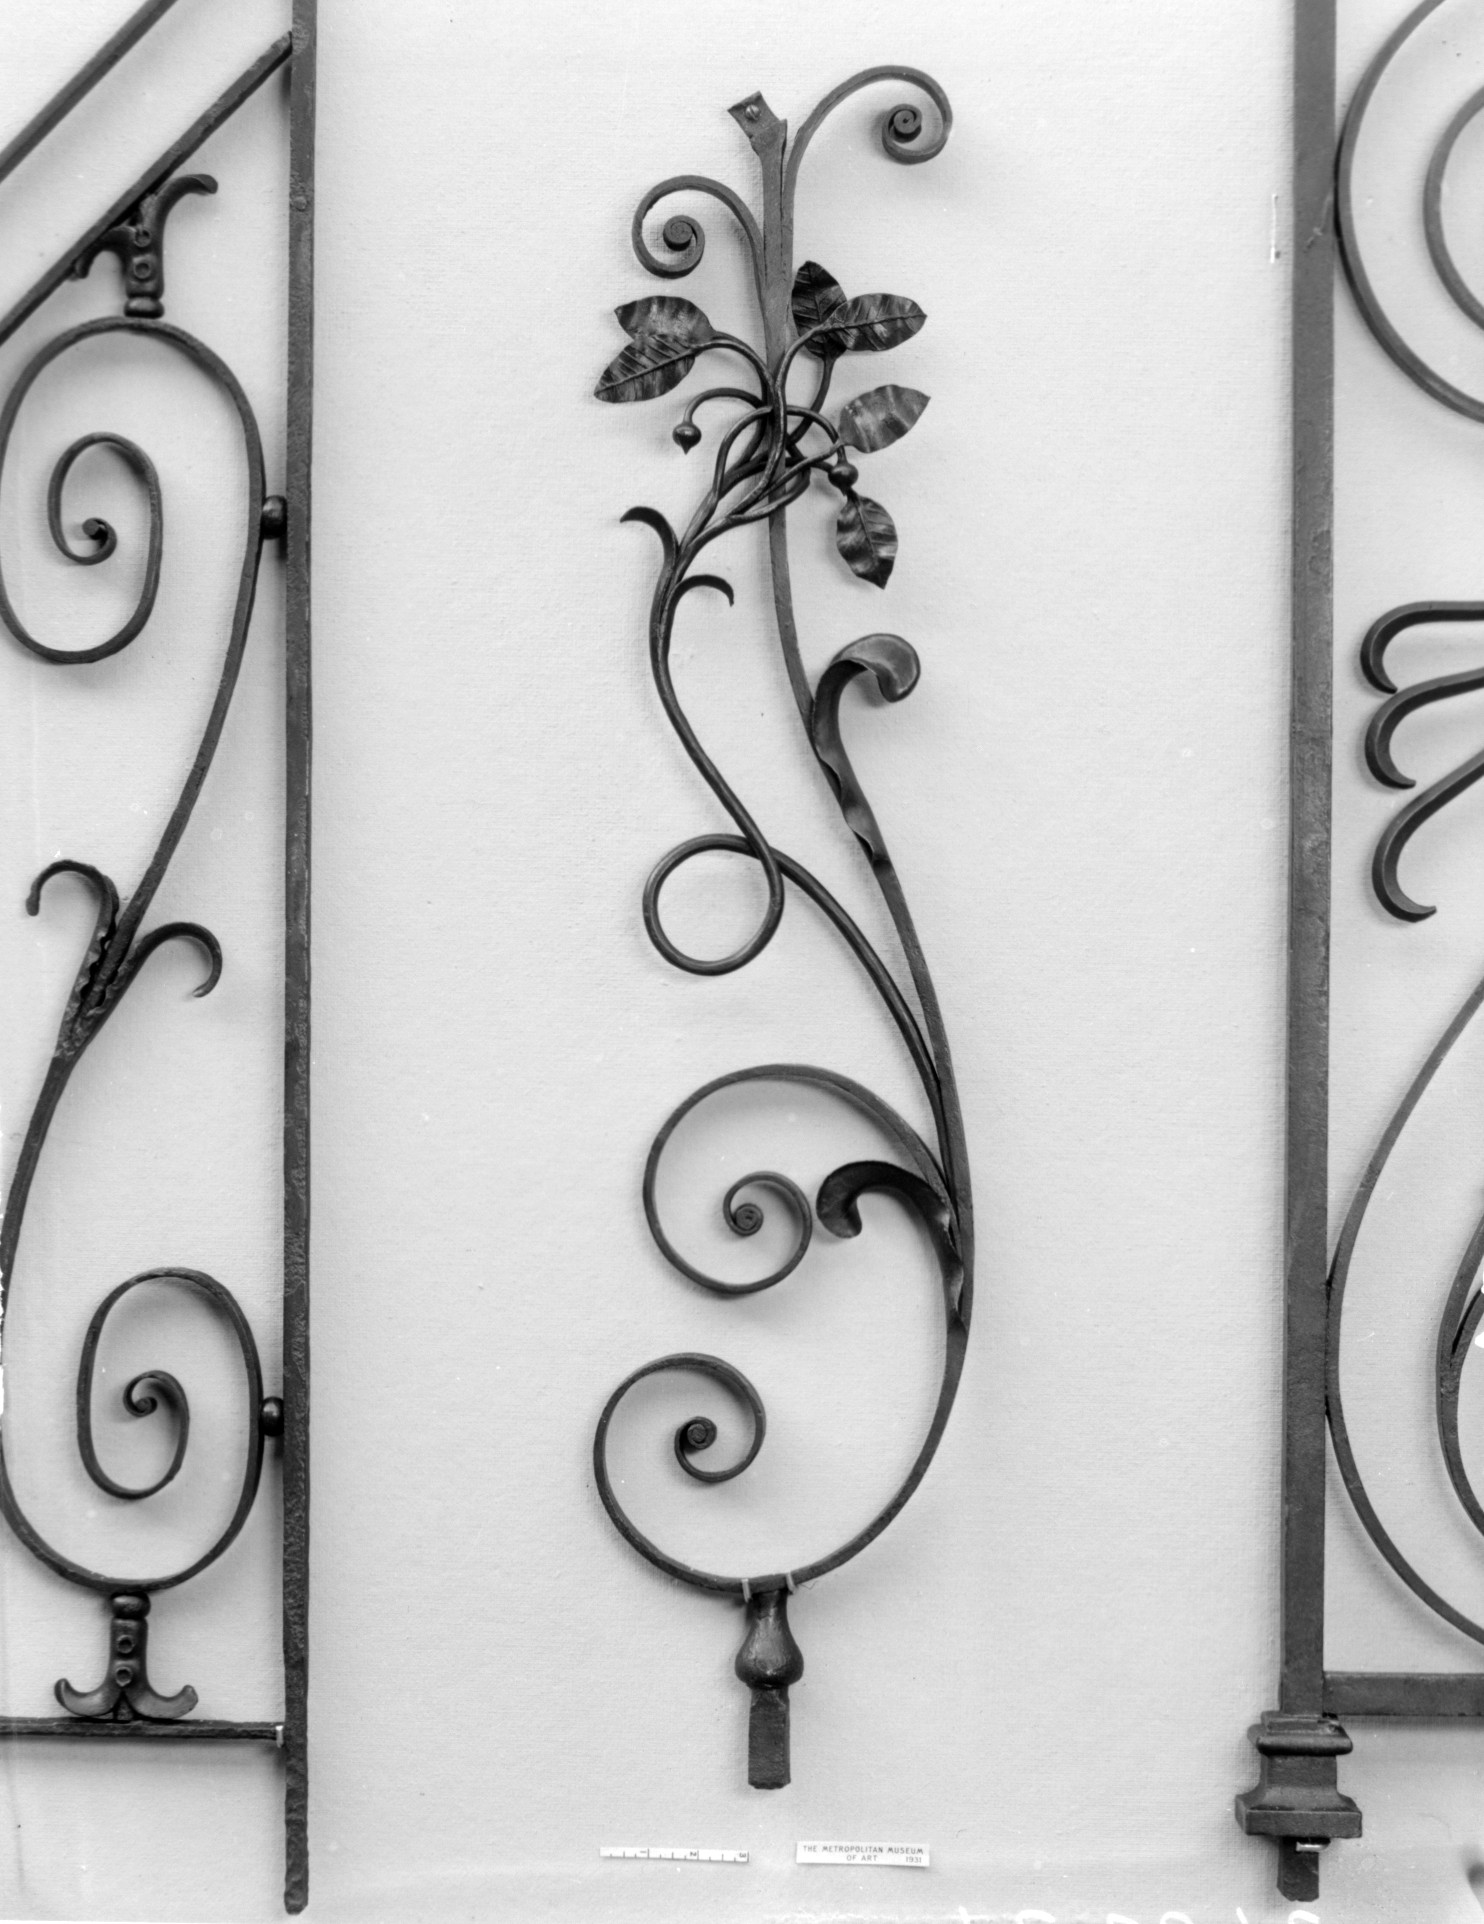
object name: baluster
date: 1760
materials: iron